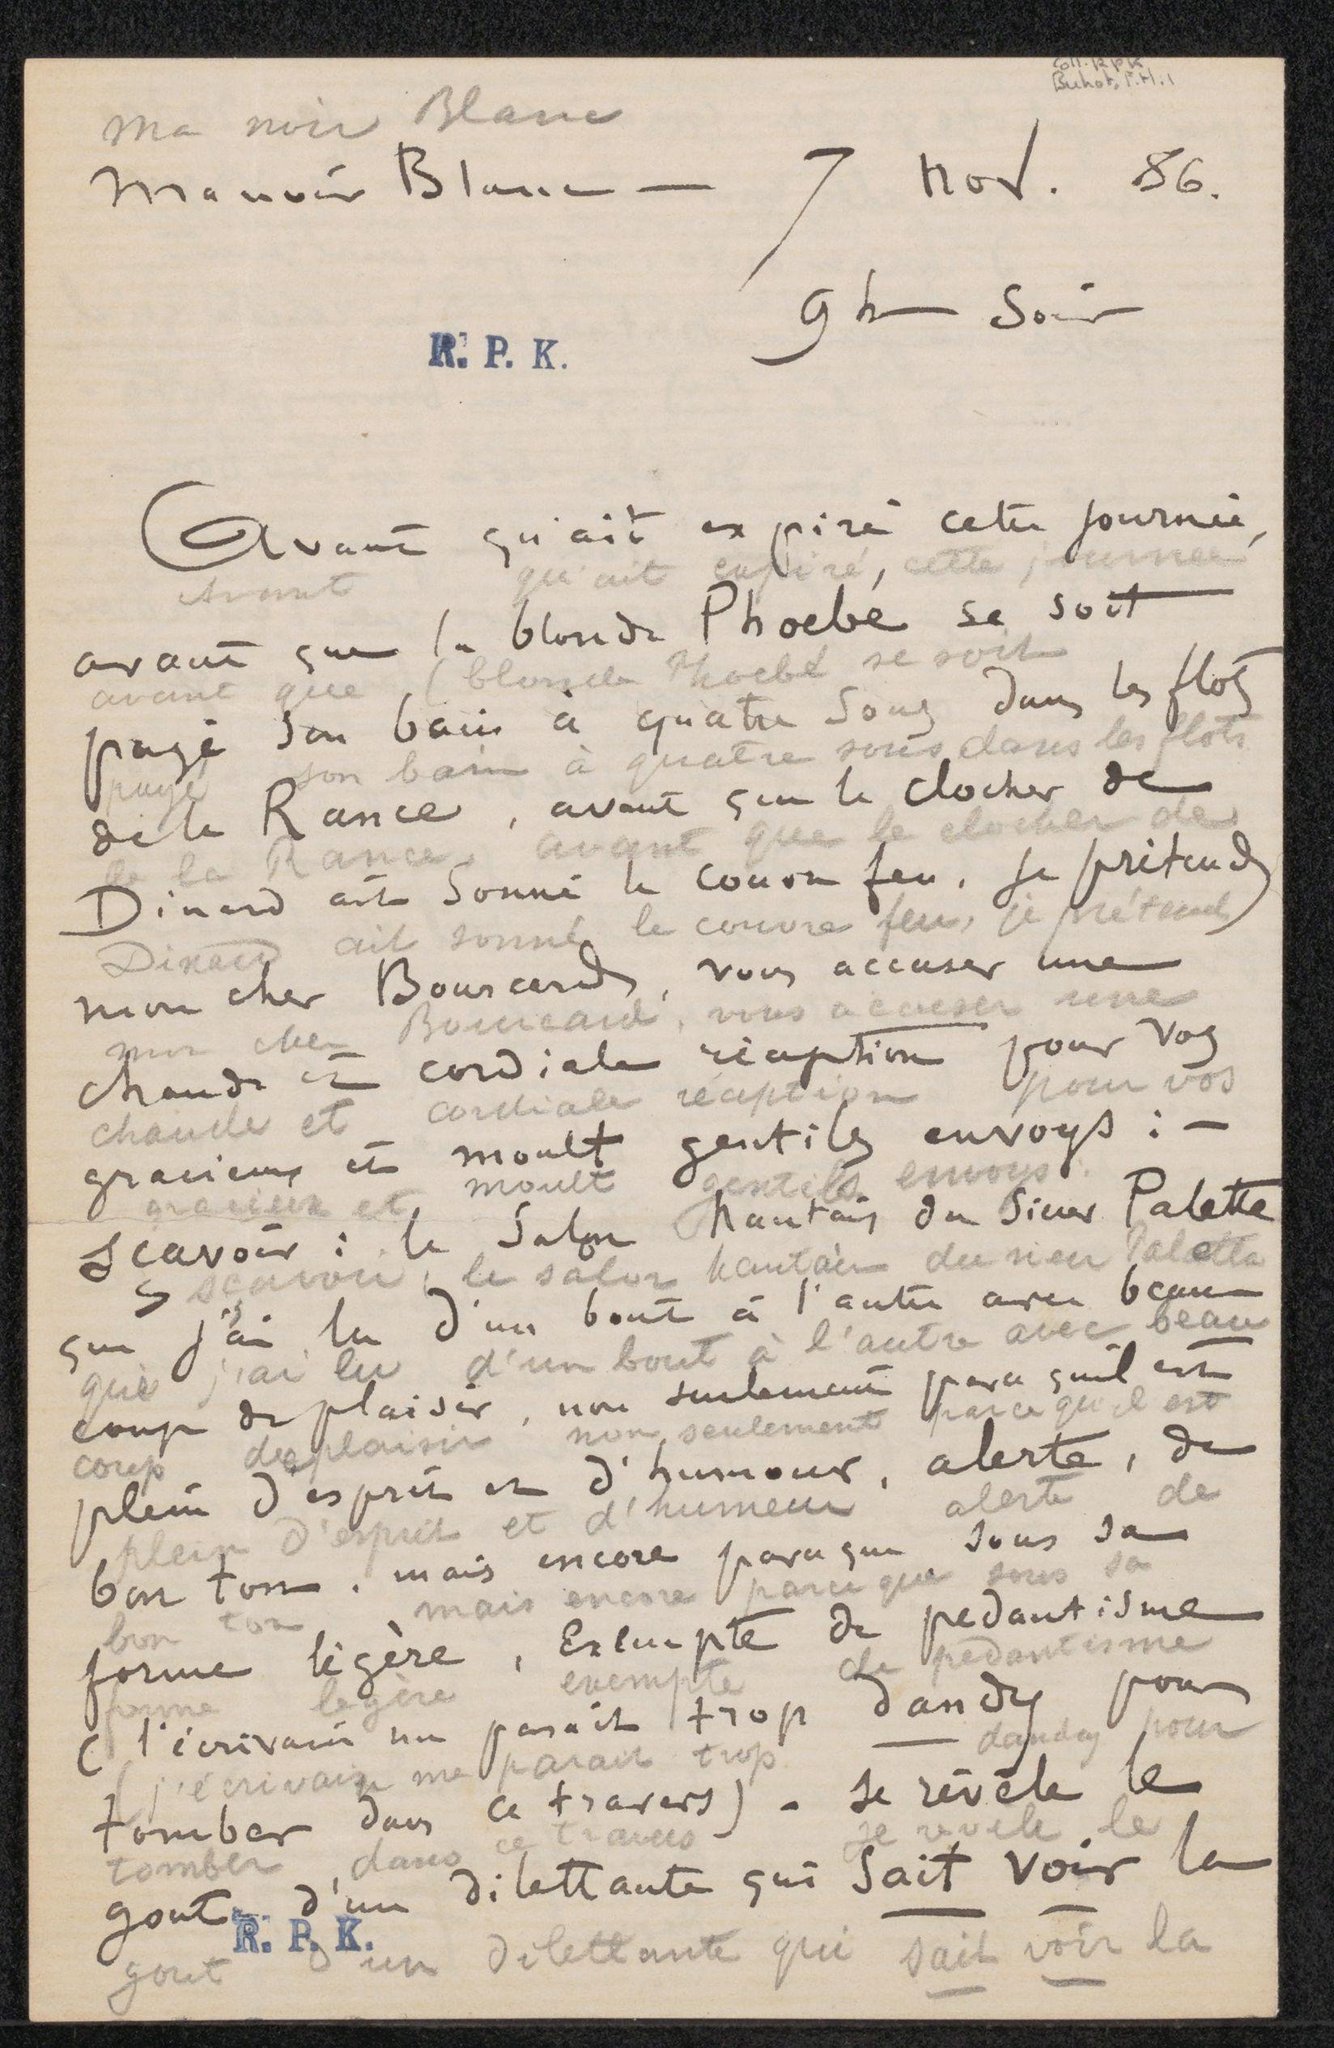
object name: letter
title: Brief aan Gustave Bourcard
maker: félix hilaire buhot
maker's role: draughtsman, print maker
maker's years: 1847-1898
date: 1886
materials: ink, paper, pencil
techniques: pen, writing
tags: françois courboin, georges rochegrosse, gustave bourcard, literature ~ arts, photography, cinematography, the graphic arts, rodents, painting (including book-illumination, miniature-painting), historical persons (portraits and scenes from the life), paris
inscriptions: collector's mark: Lugt 2233